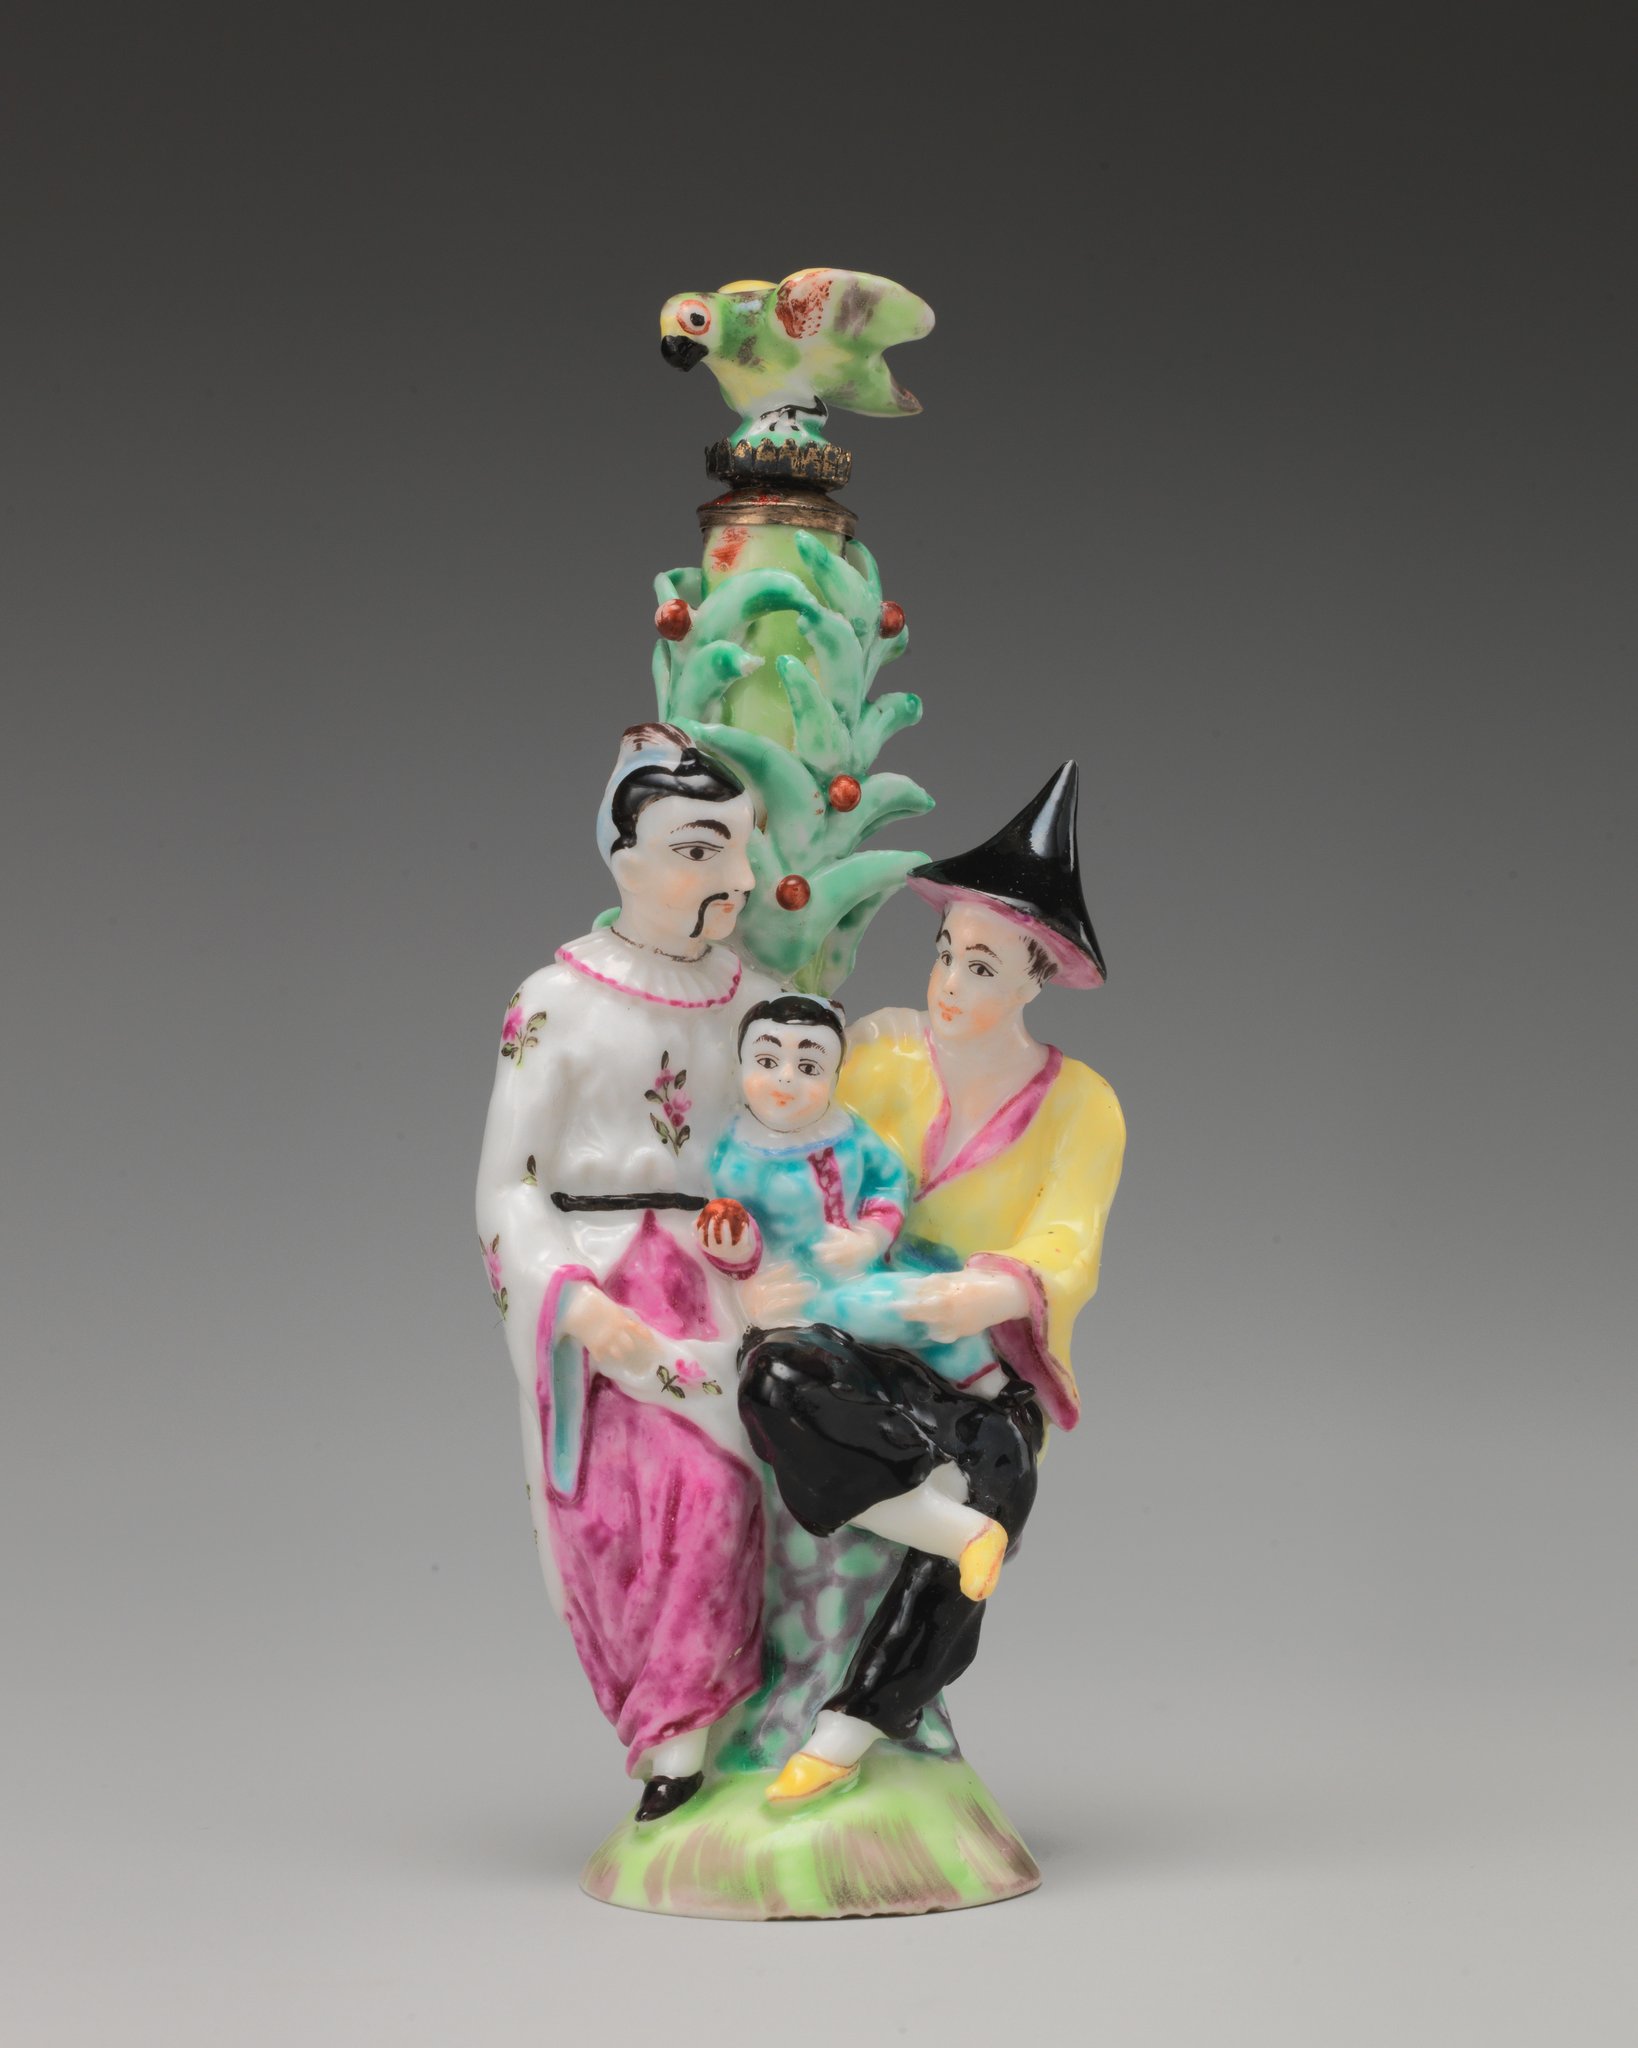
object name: toy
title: Chinese family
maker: saint james's factory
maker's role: maker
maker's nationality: british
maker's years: 1749-1759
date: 1750-1755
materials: soft paste porcelain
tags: chinoiserie,children,men,women,family